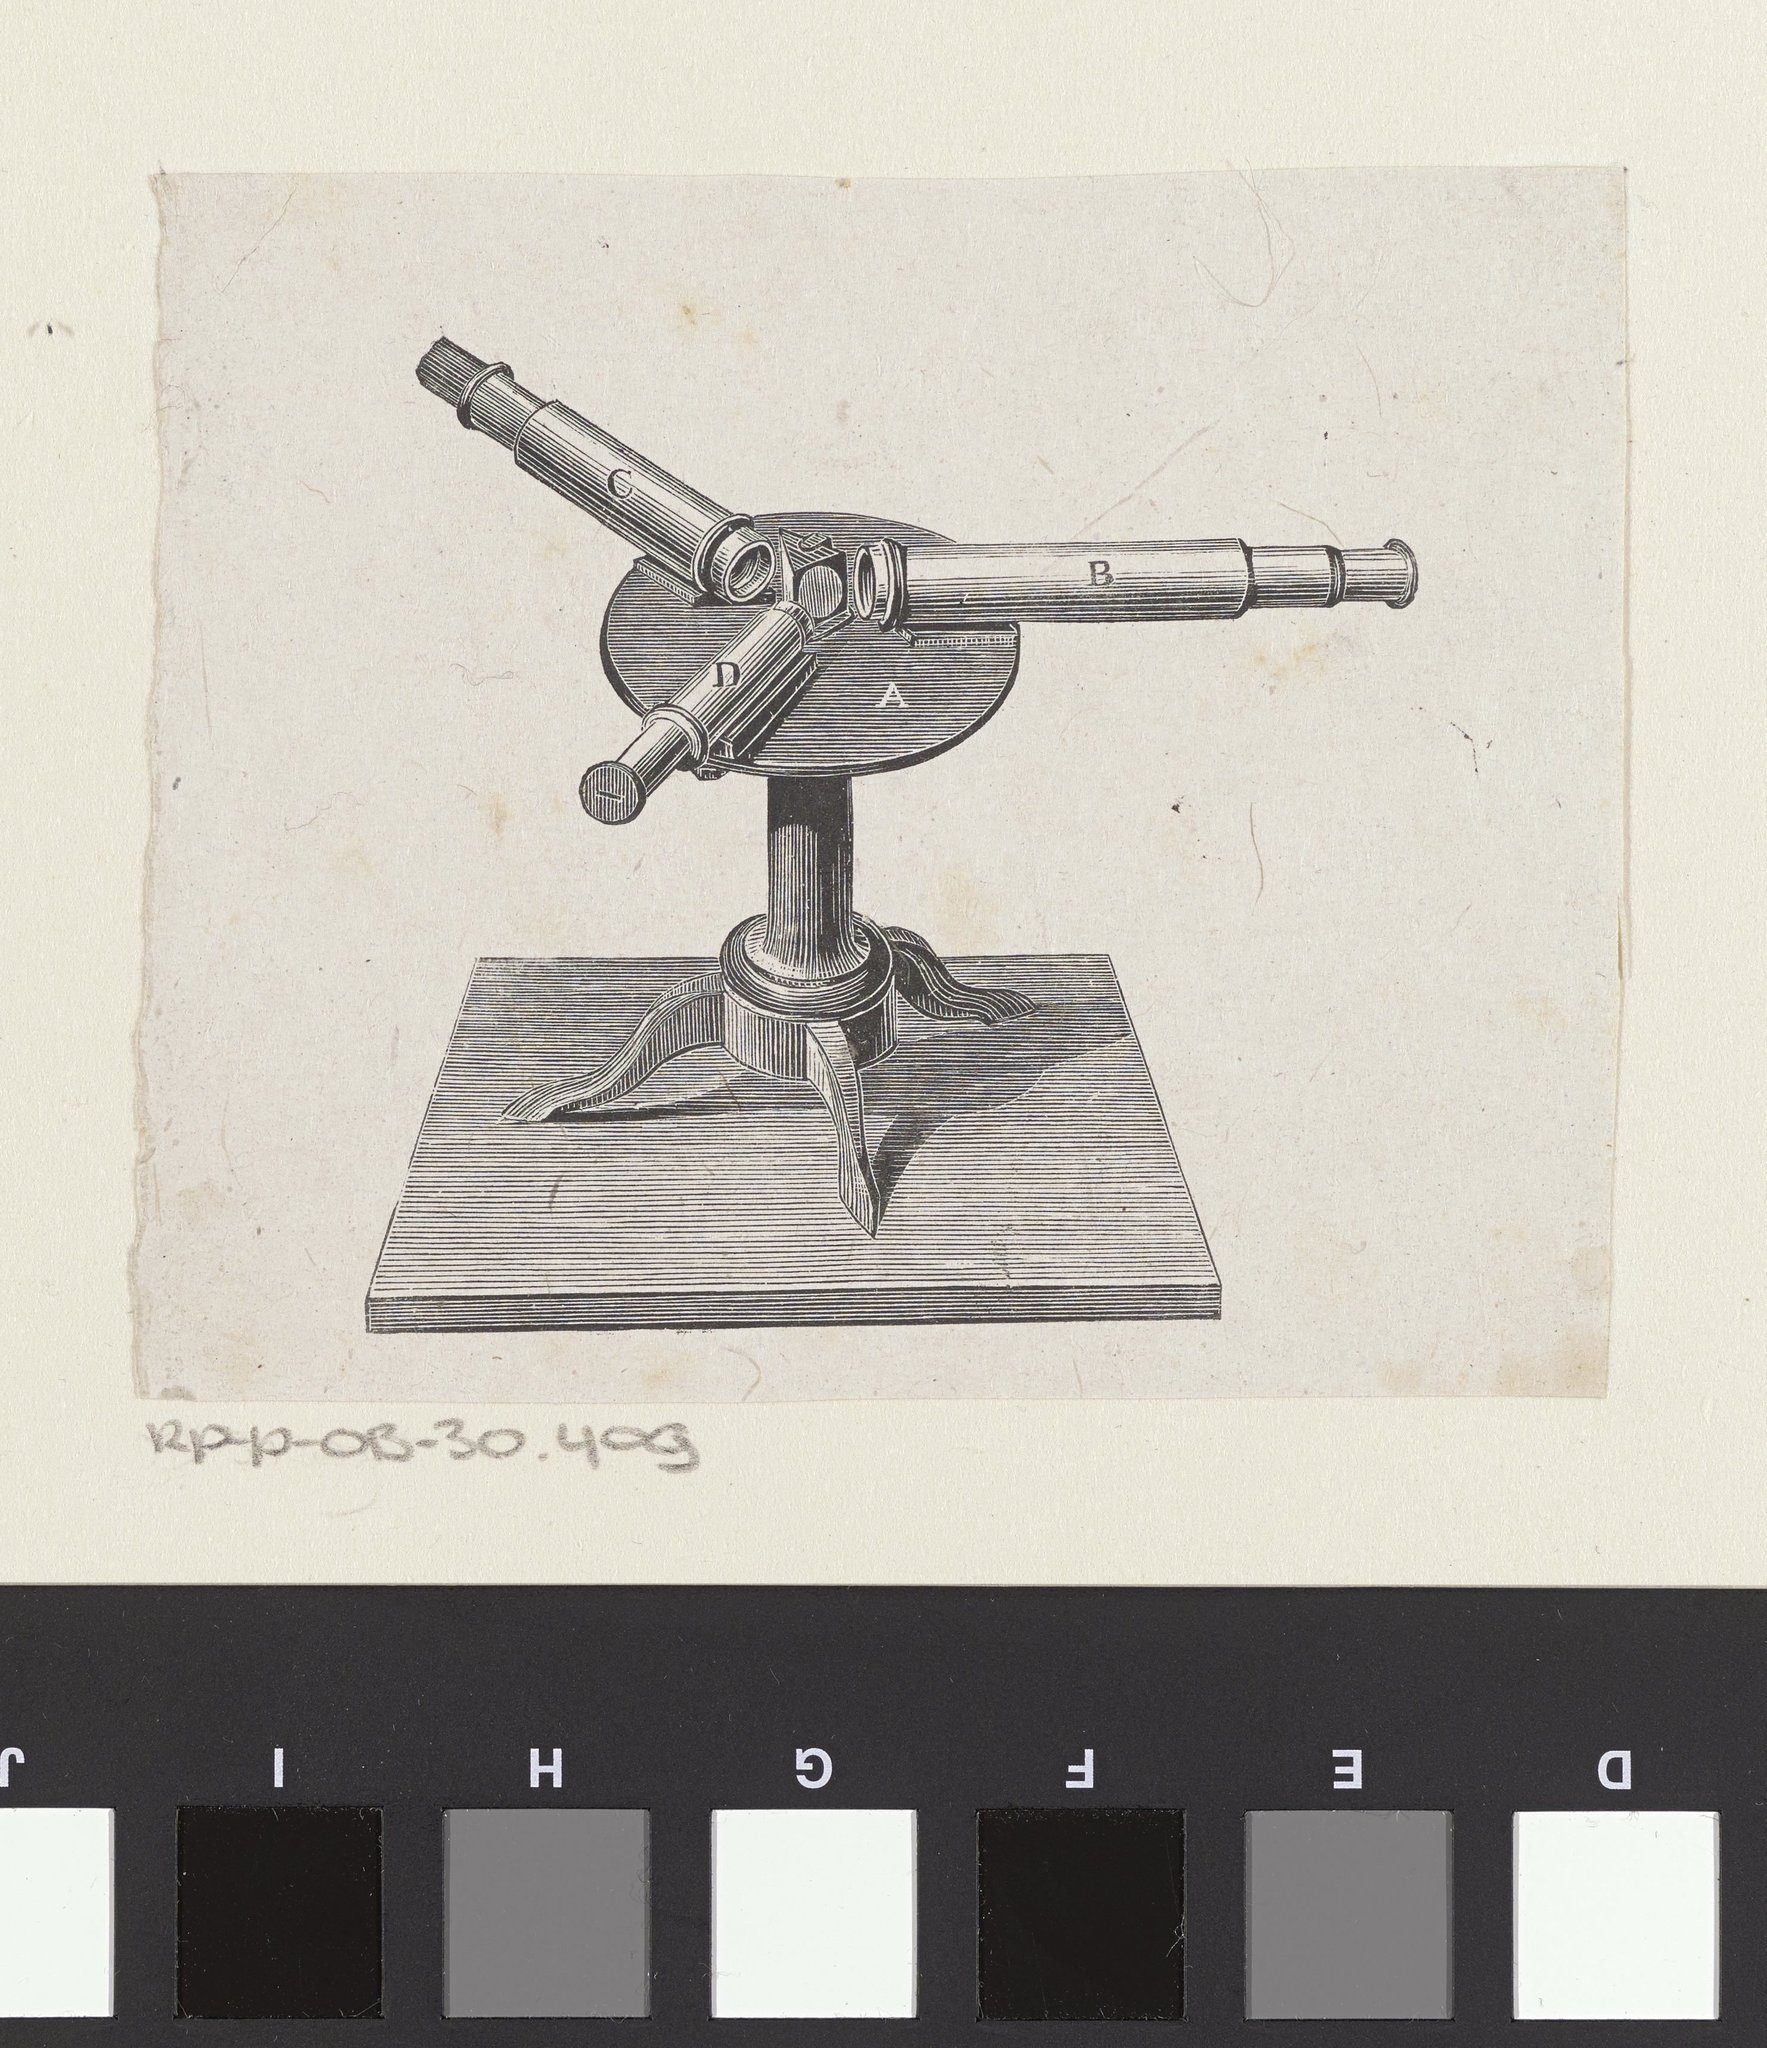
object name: print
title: Spectroscoop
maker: isaac weissenbruch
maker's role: print maker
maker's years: 1826-1912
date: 1836-1912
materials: paper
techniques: engraving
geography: netherlands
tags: optical instruments